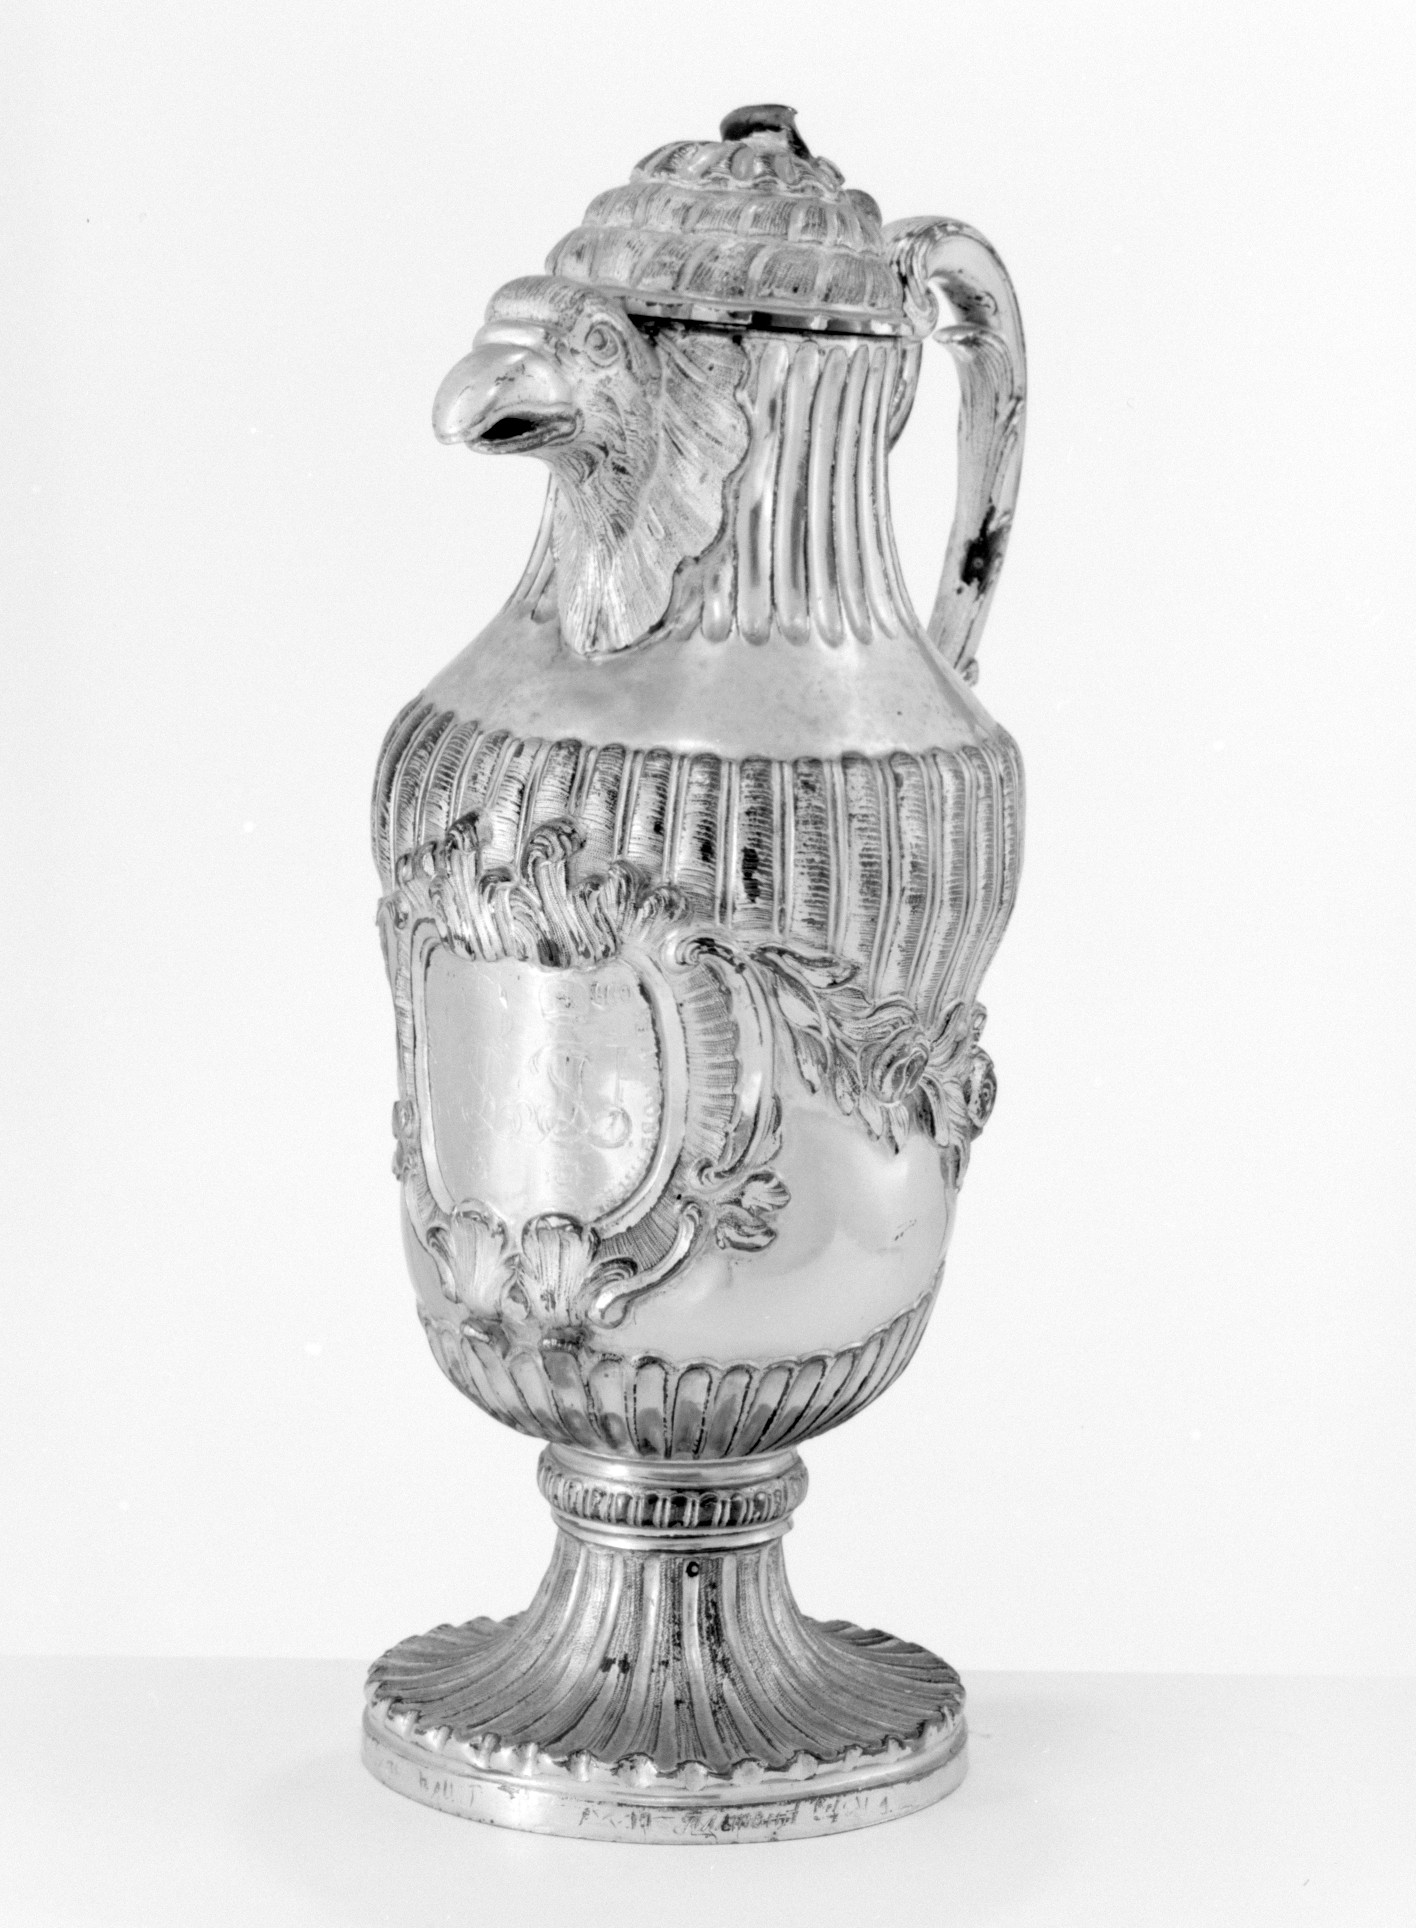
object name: ewer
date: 1801-1900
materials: gilt, silver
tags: birds